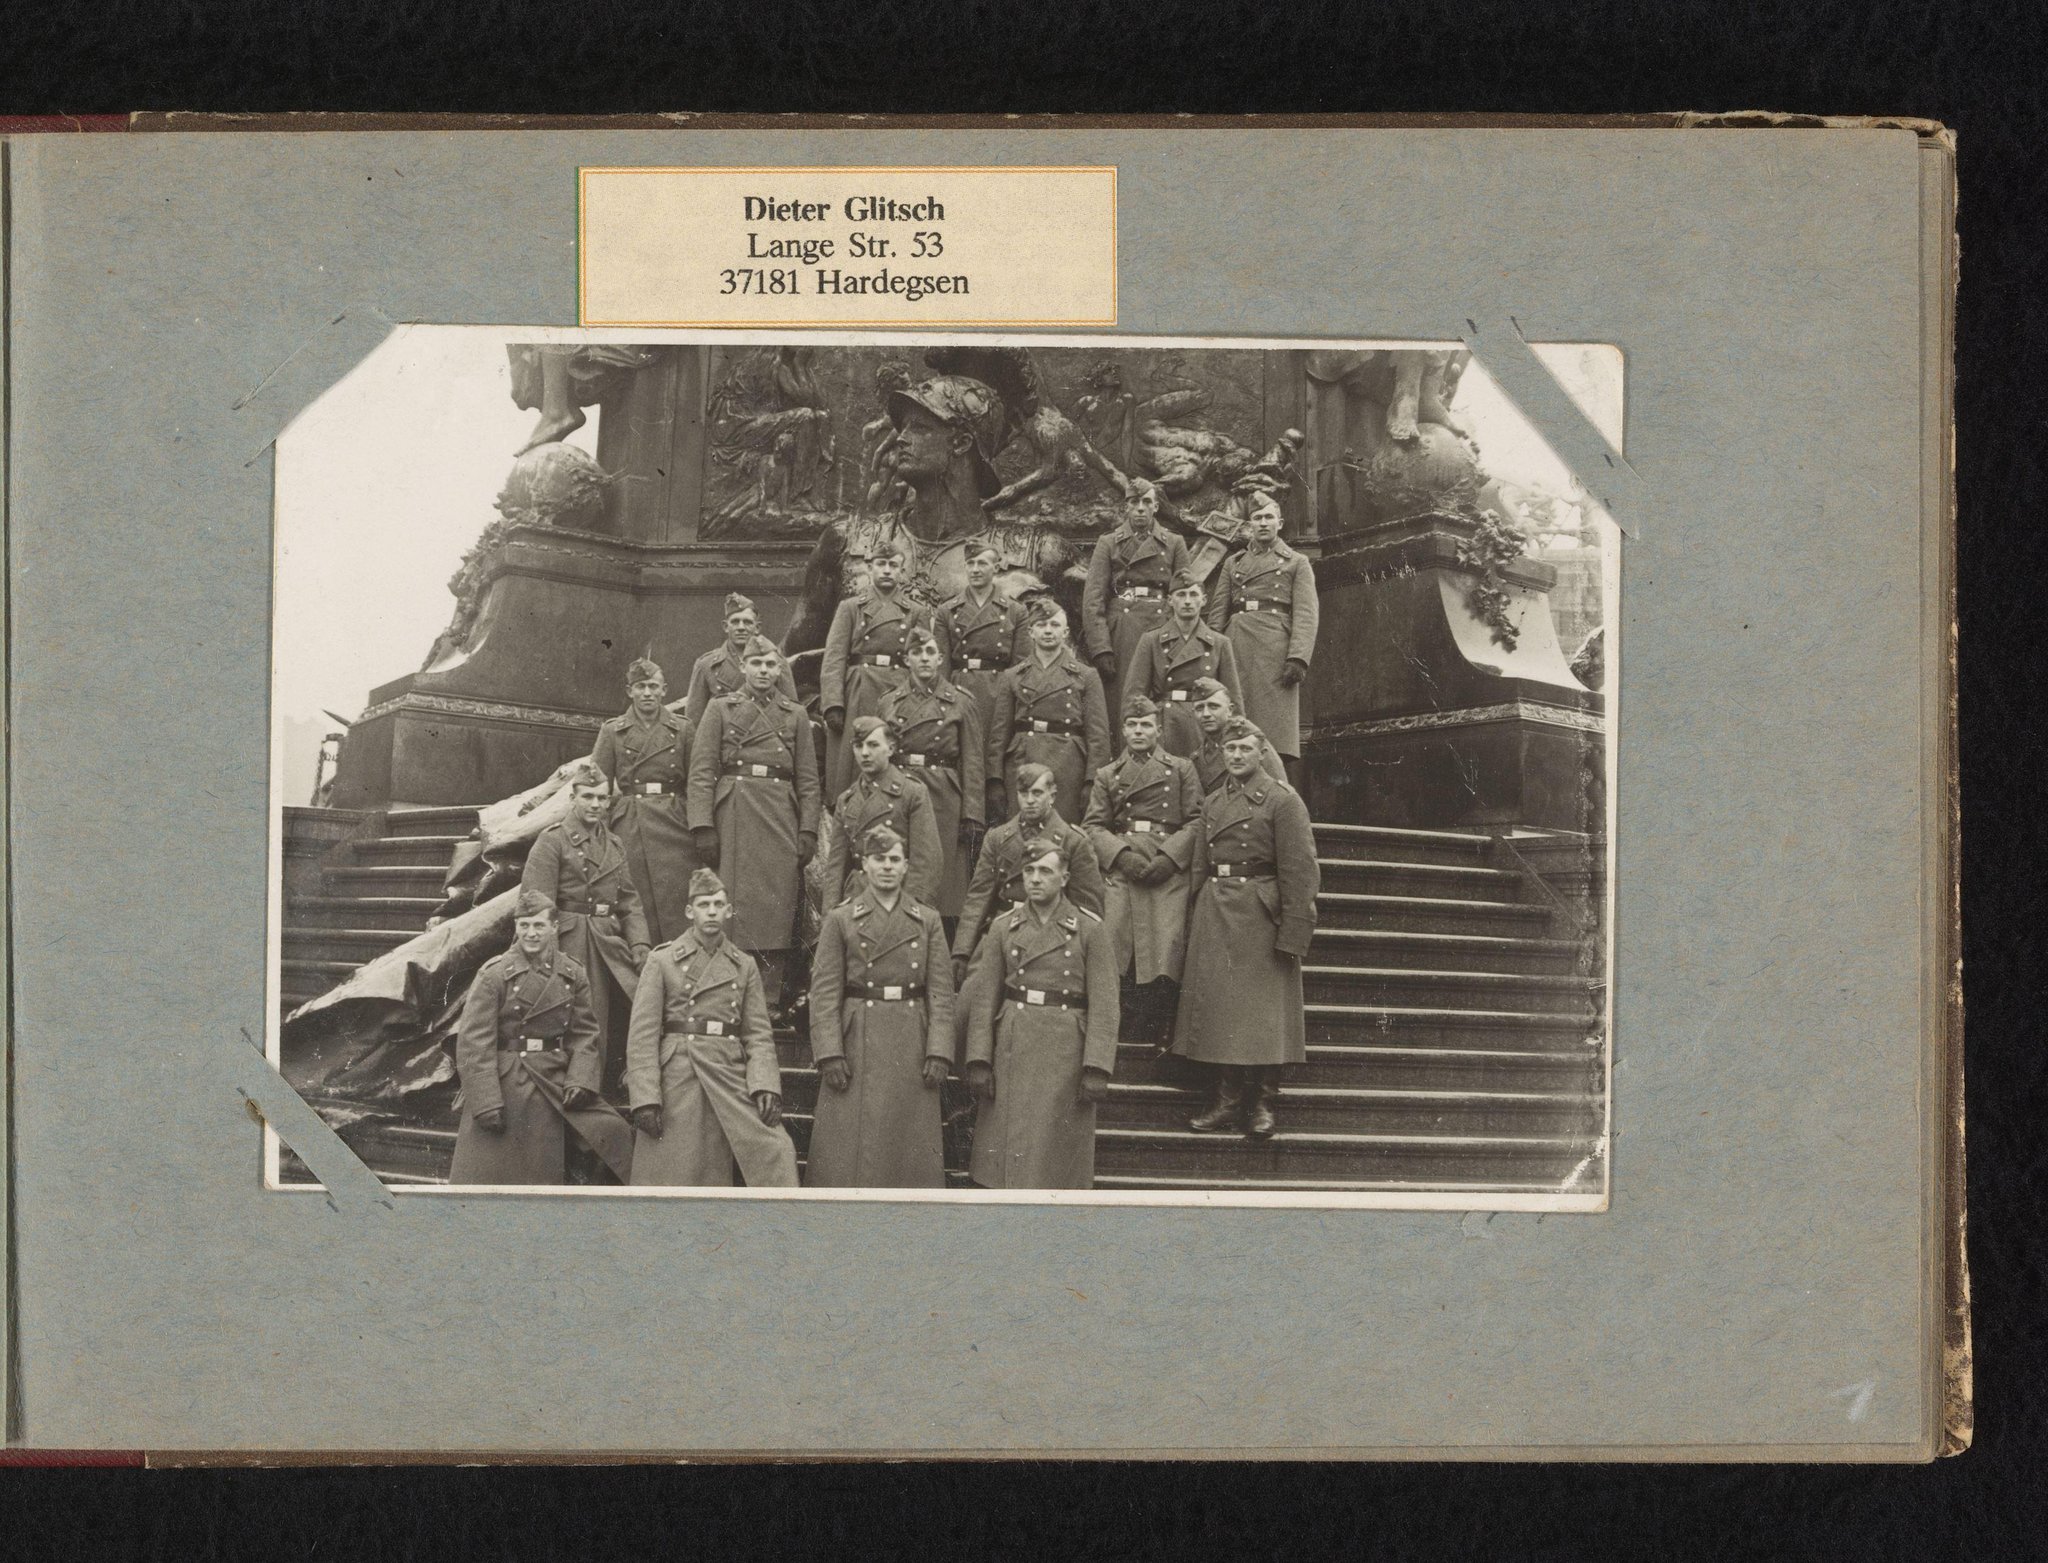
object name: photograph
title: Groepsfoto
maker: Anonymous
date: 1940-1945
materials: paper, photographic support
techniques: gelatin silver print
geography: germany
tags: the company, the unit, the troop ~ military service, germany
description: Albumblad met een foto van een eenheid van de Luftwaffe poserend op de trappen voor een monument. Boven de foto een geplakt etiket met naam en adres van Dieter Glitsch. Onderdeel van een fotoalbum over de diensttijd van Dieter Glitsch uit Hardegsen tijdens de Tweede Wereldoorlog en de jaren daarna.